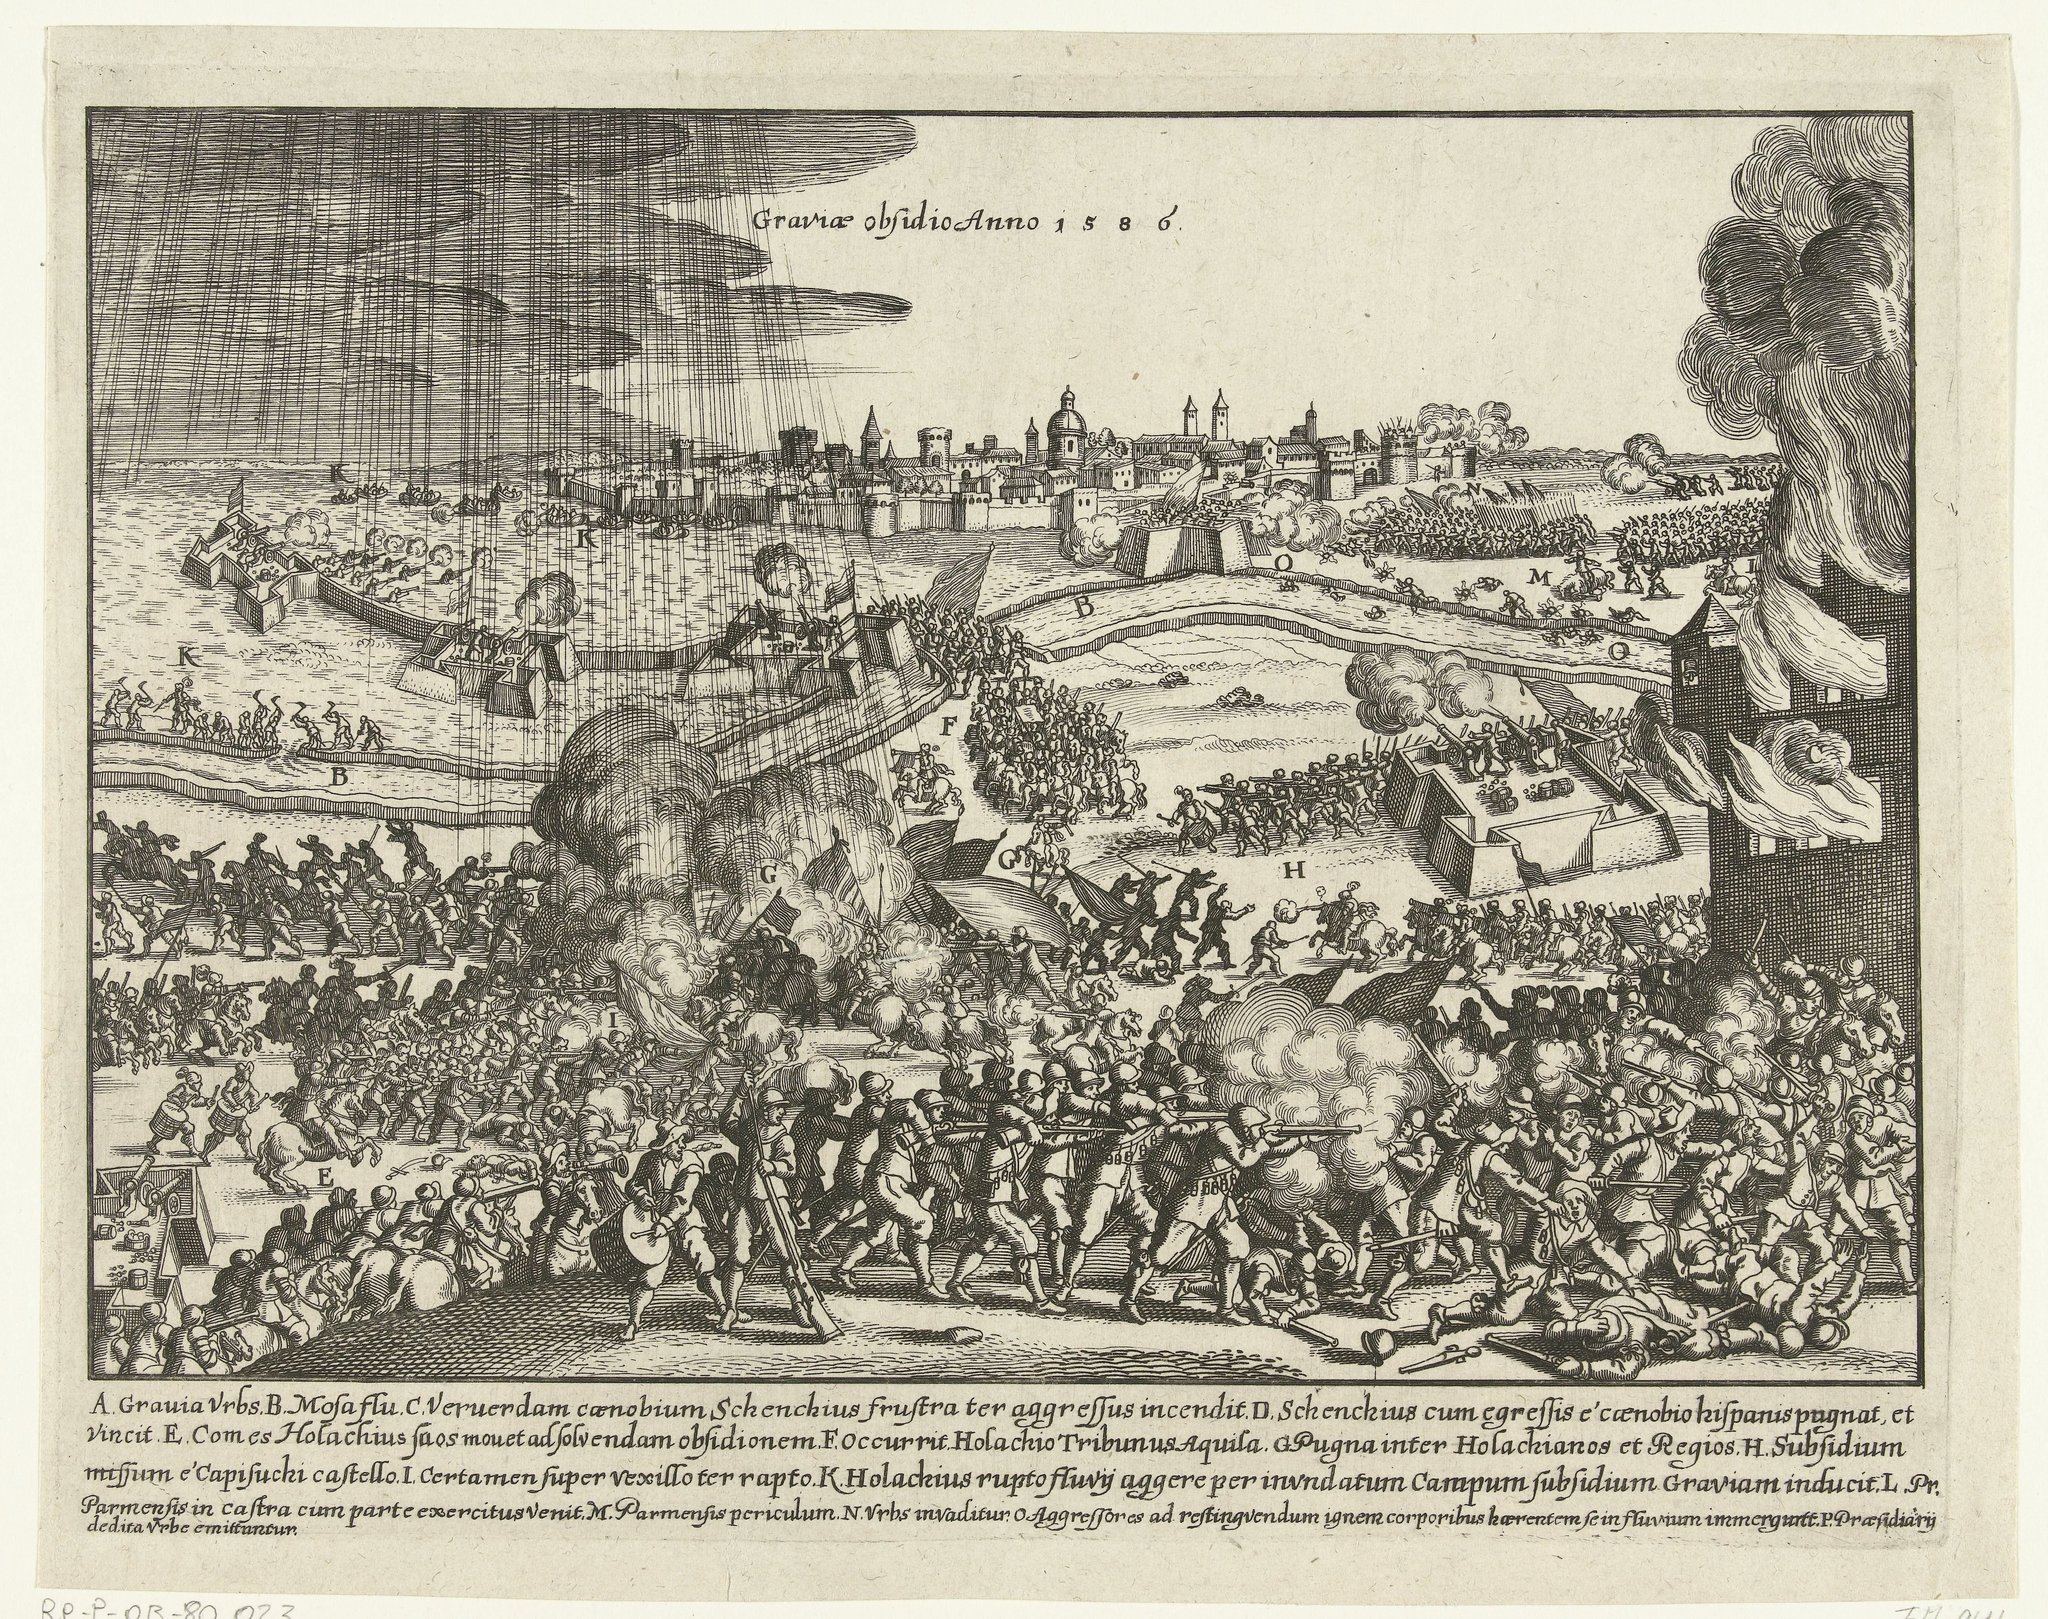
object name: history print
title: Graviae obsidio Anno 1586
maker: Anonymous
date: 1649-1651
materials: paper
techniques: etching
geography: rome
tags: rome, alessandro farnese (landvoogd van de nederlanden en hertog van parma en piacenza), siege, position war, grave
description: Gebruikt als illustratie in: F. Strada, De Bello belgico decades duae auctiores et correctiores cum figuris encis prodeunt a Famiano Strada Soc: Jesu Romano Moguntiae 1651. Kopie naar de prent van F. Collignon in de oorspronkelijke editie van 1647, zie FMH 940.